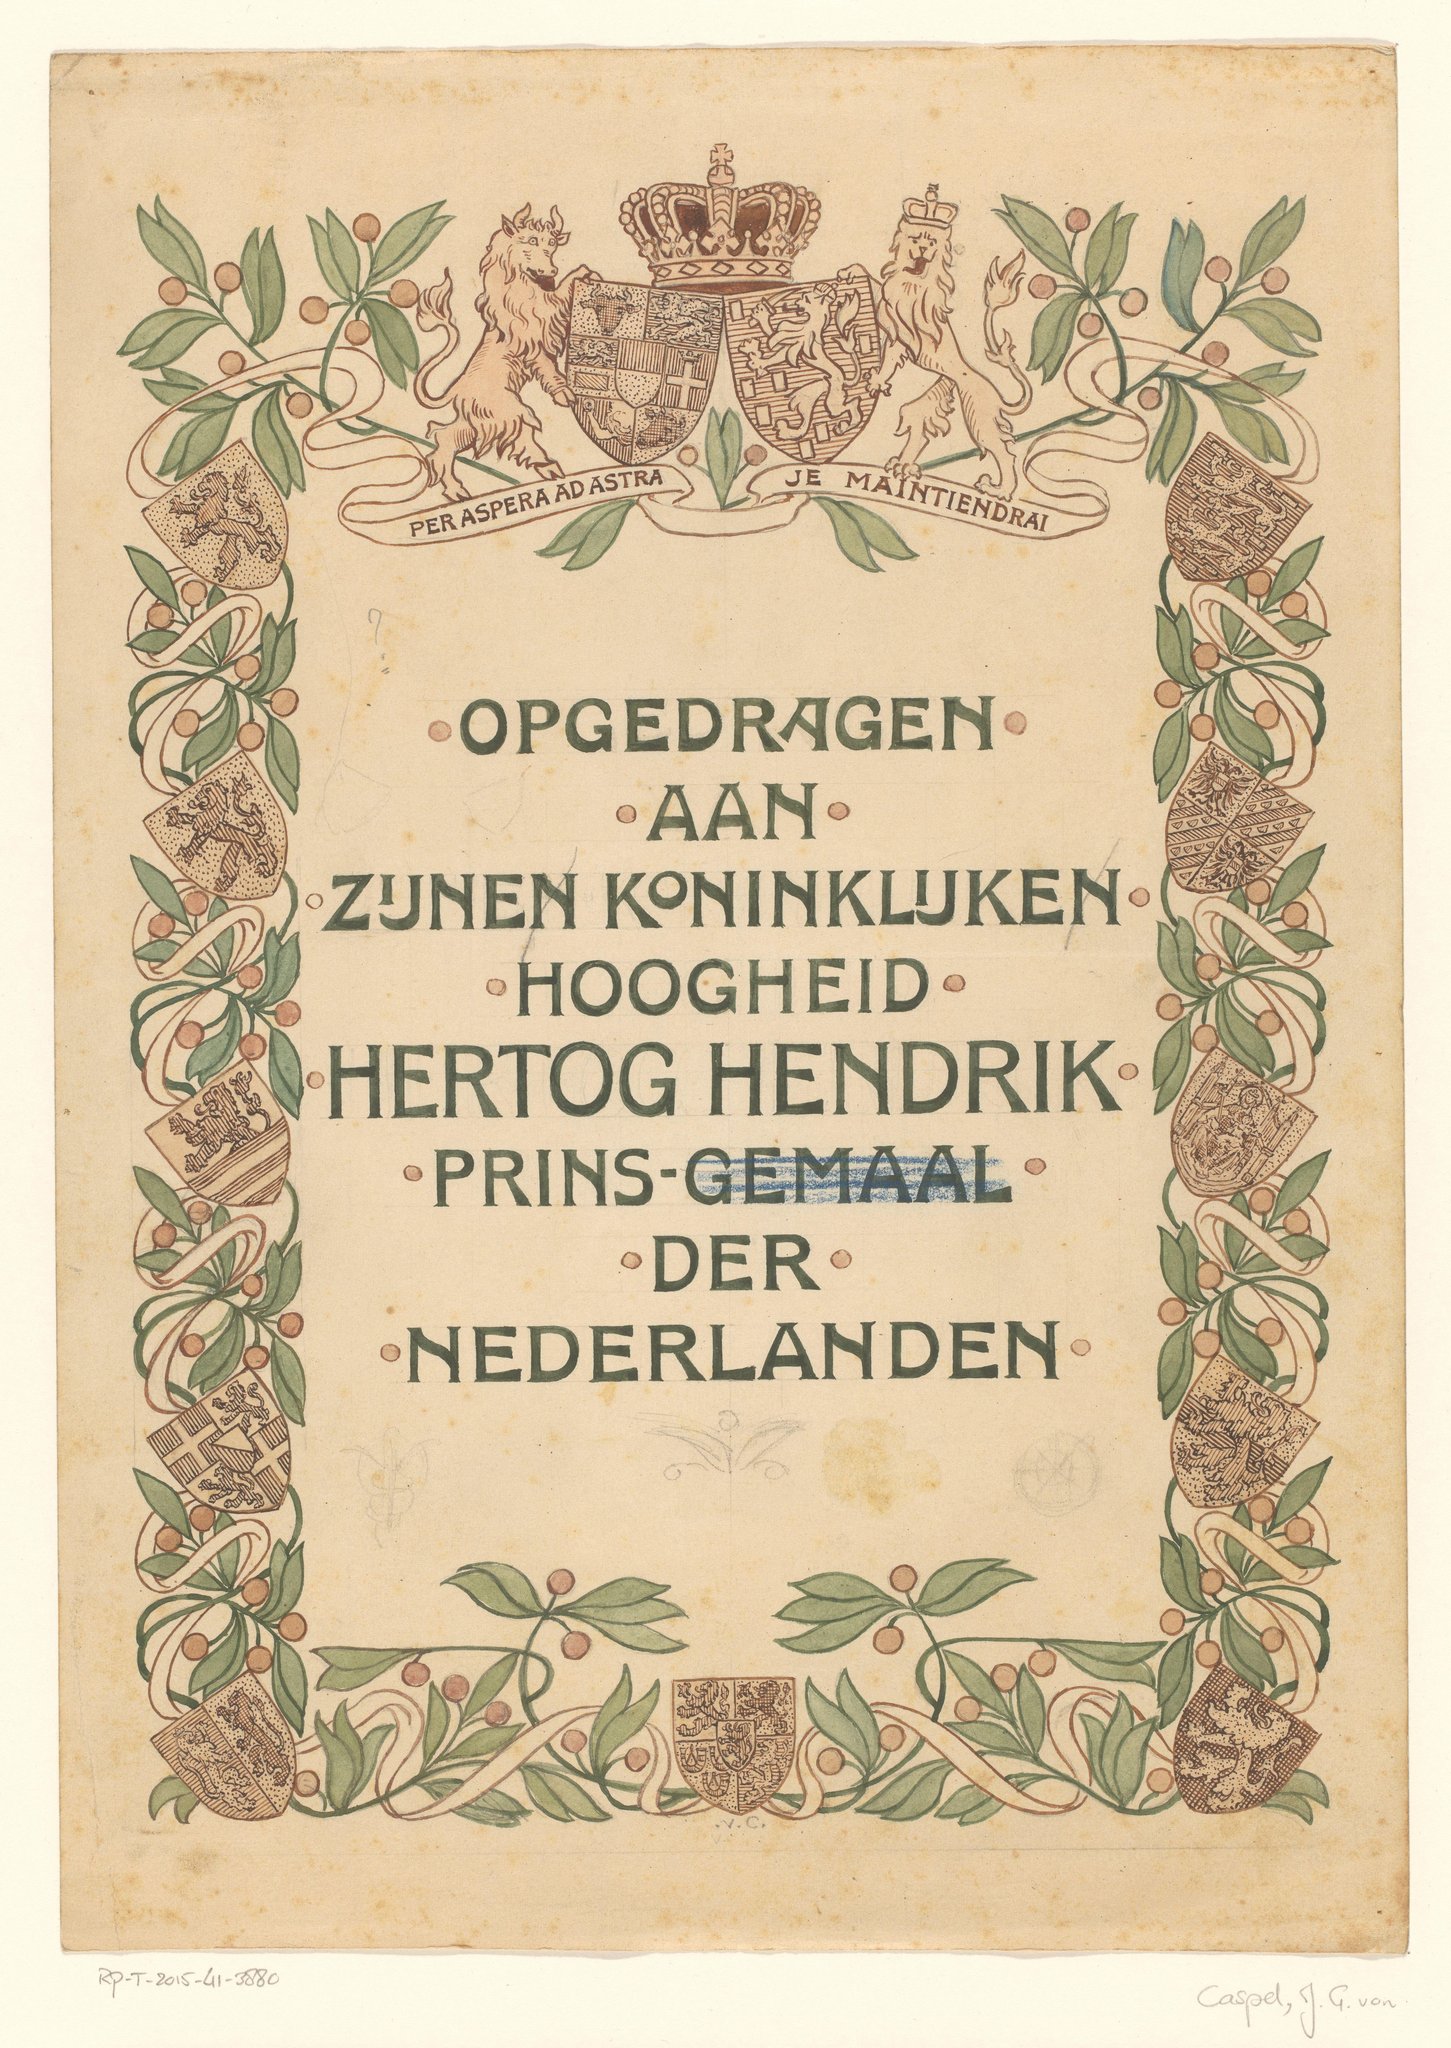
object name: design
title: Omslagontwerp voor: De Nederlandsche handel en nijverheid in woord en beeld, 1901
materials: ink, paper, pencil, watercolor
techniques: brush, pen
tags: the hague, hendrik (prins der nederlanden (1876-1934)), ornament derived from plant forms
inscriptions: collector's mark: Lugt 2228a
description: Rechthoekig kader met bladeren, bessen en elf wapens van de provincies van Nederland. Bovenaan het wapen van het Koninkrijk der Nederlanden en het wapen met de lijfspreuk van prins Hendrik.